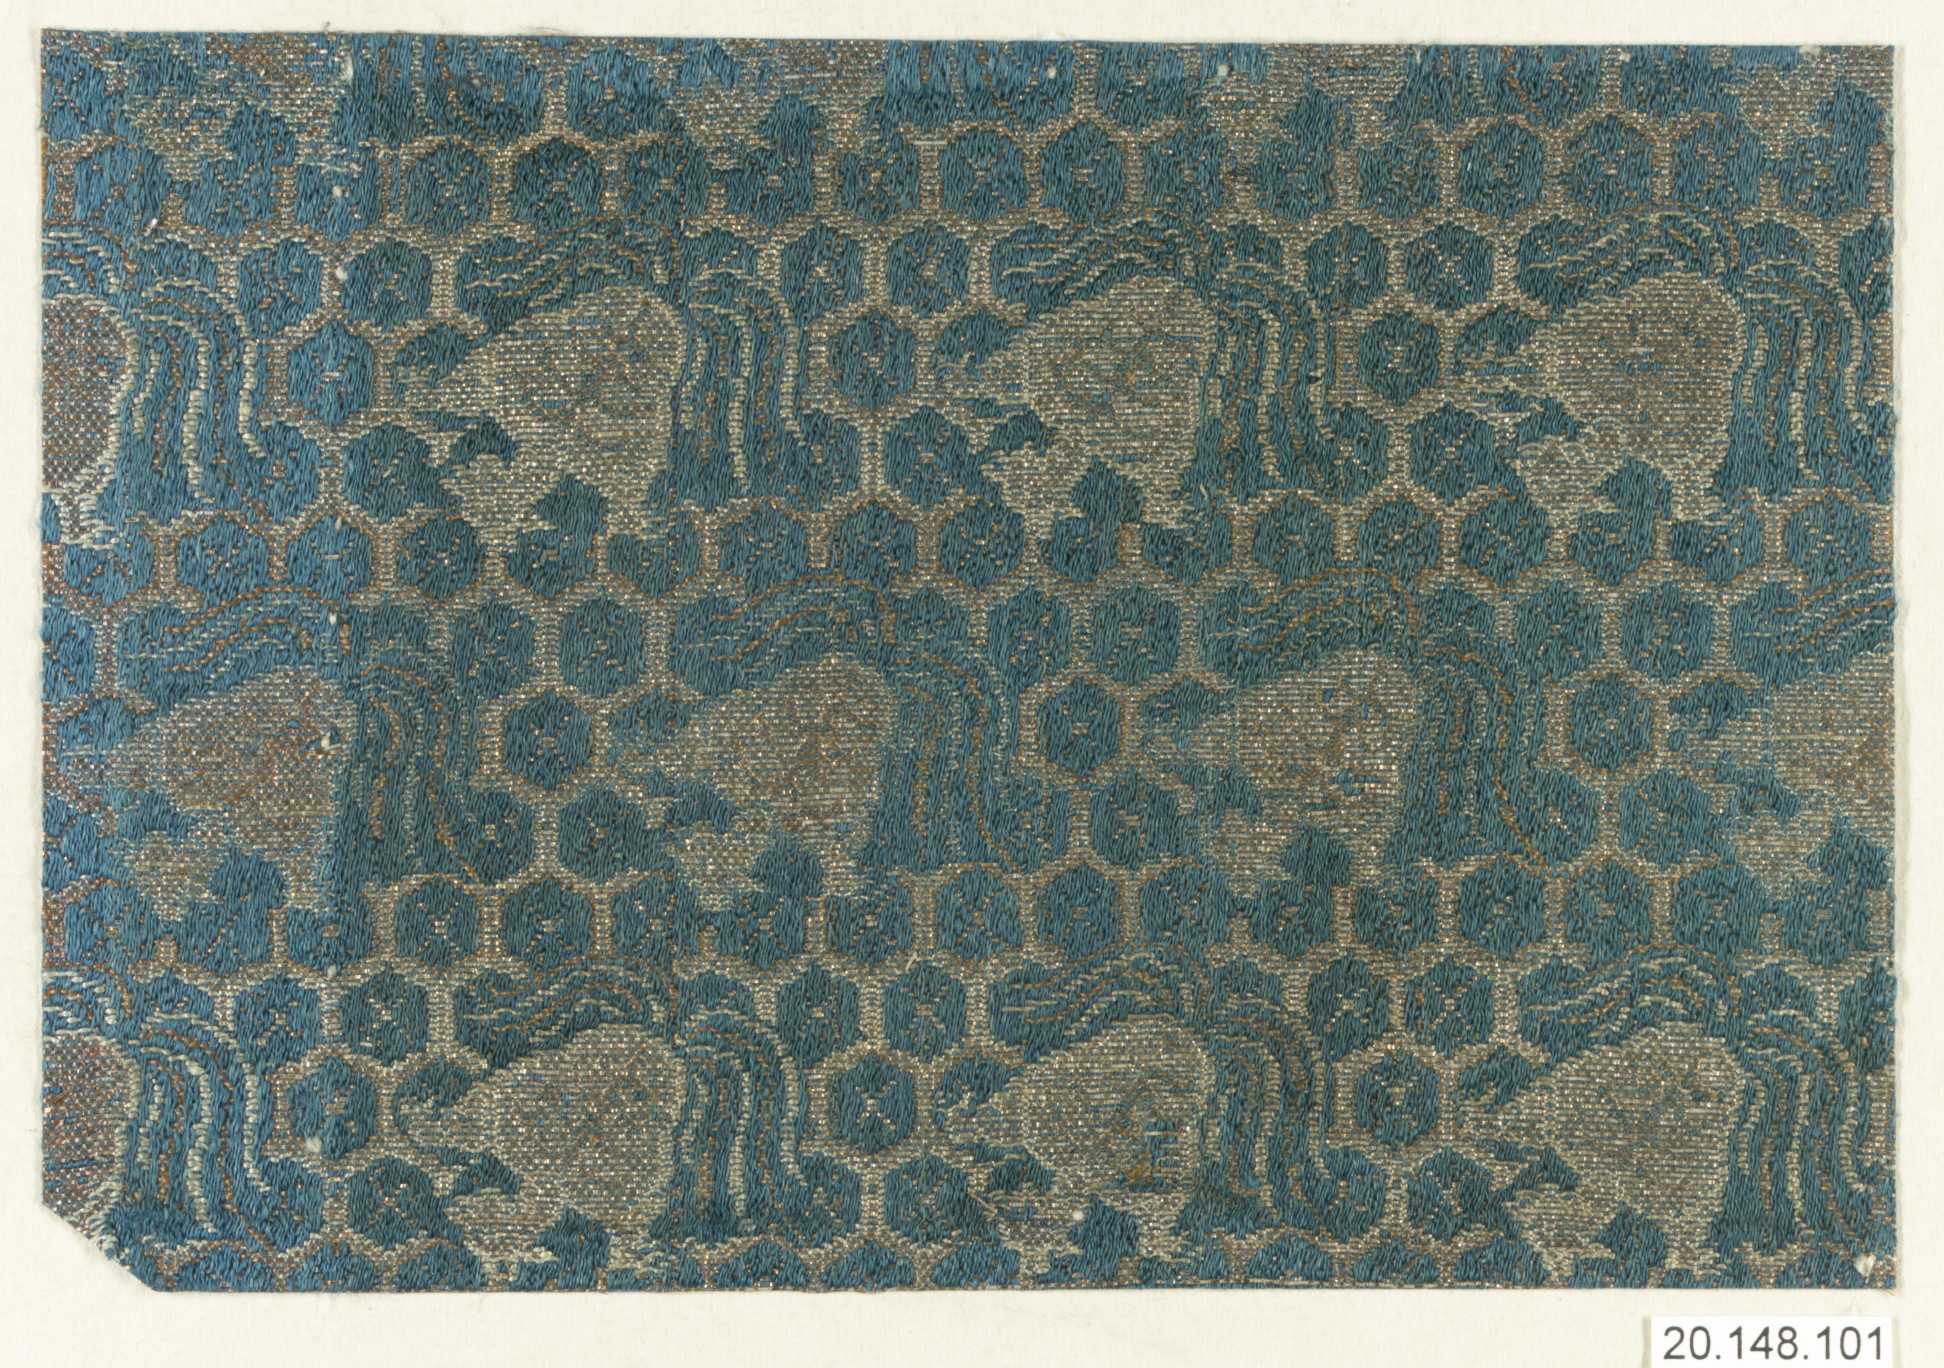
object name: piece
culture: japanese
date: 1601-1700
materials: silk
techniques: compound weave